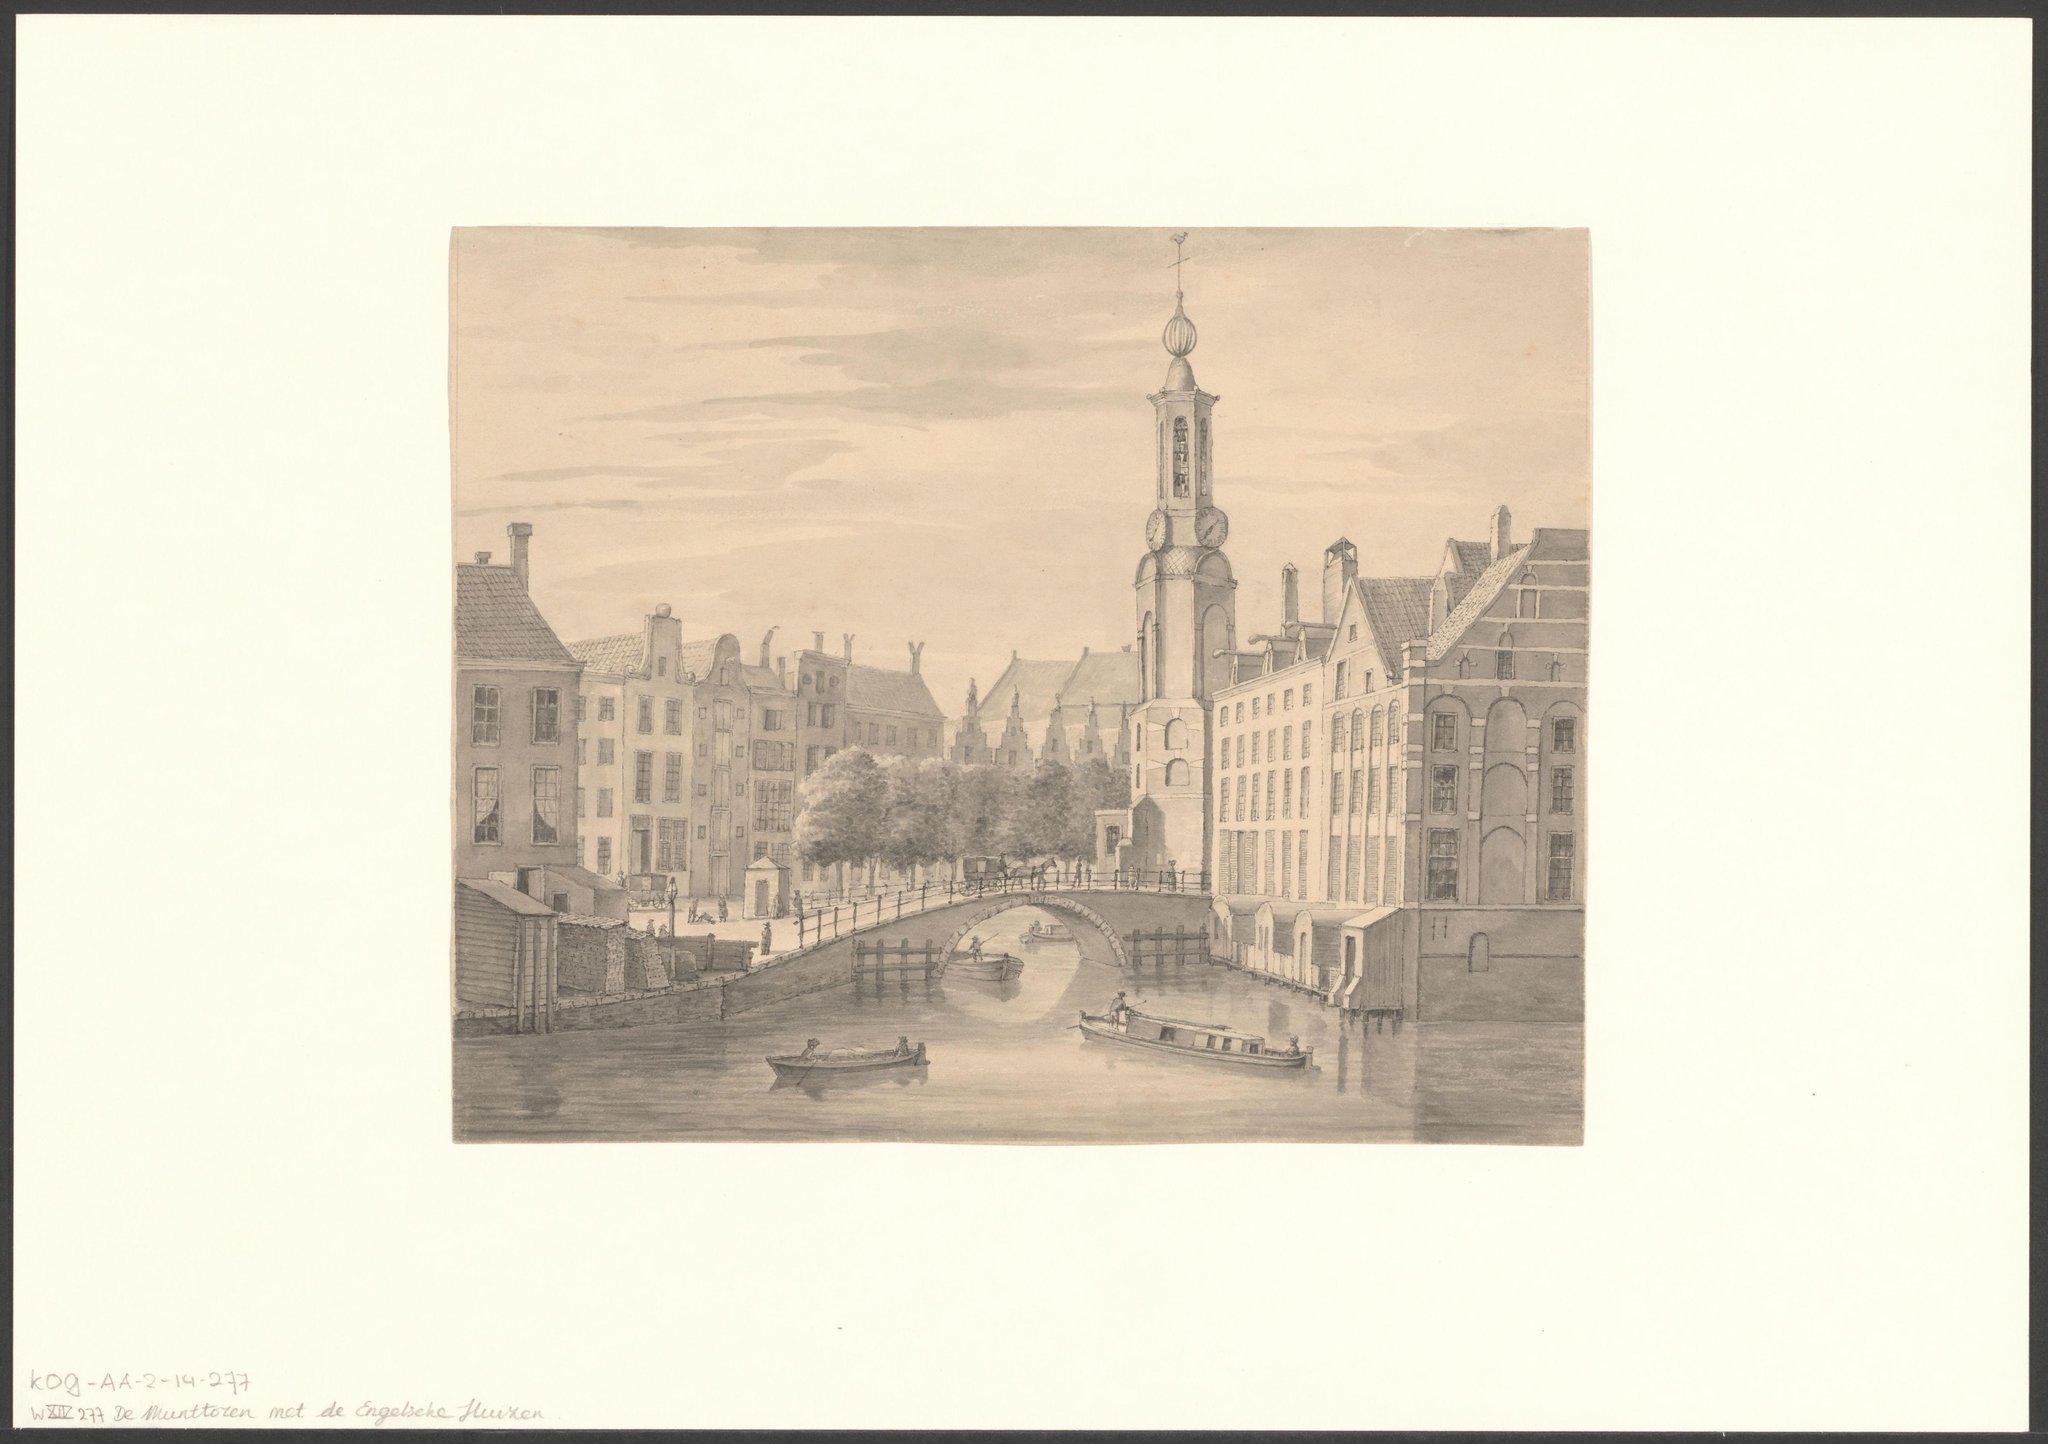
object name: drawing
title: Gezicht op de Engelse huizen en de Munttoren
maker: Anonymous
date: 1847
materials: ink, paper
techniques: brush, pen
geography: amsterdam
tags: tower, clock tower ~ monumental adornment, city-view in general; 'veduta', canal, bridge in city across river, canal, etc.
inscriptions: inscription: ‘De munttoren te / Amsterdam / 1847’, collector's mark: Lugt 800a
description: Tekening binnen de Atlas Van Eck ingedeeld op wijknummer 14.